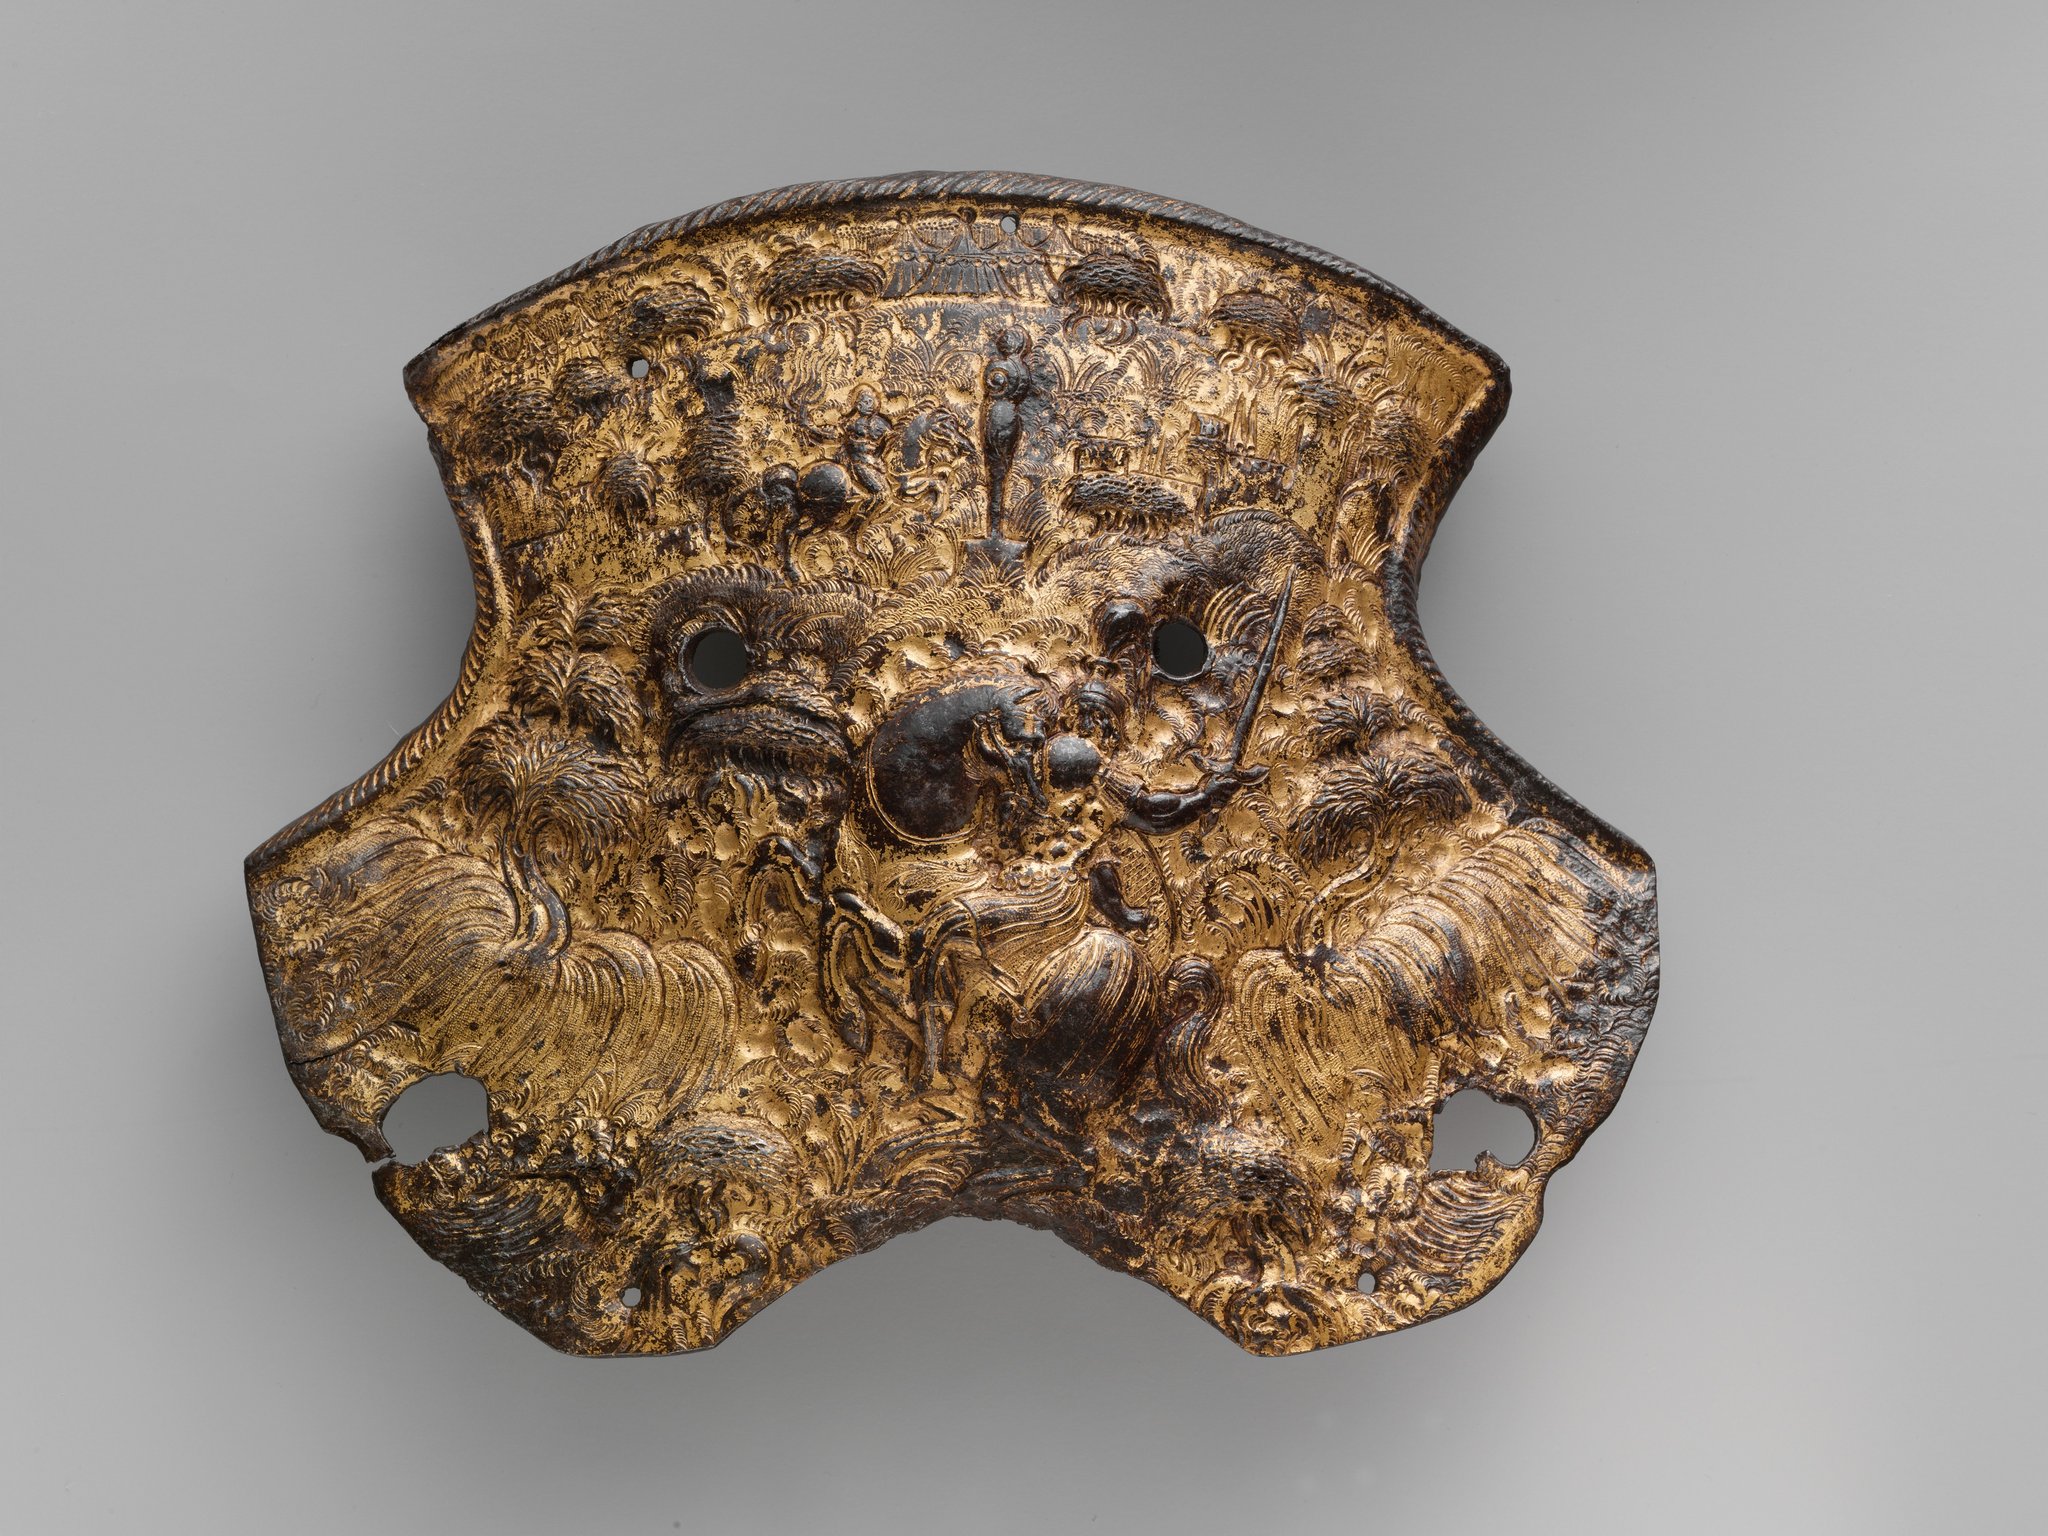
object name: pommel plate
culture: flemish or french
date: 1580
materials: gold, steel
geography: france or belgium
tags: men,horses